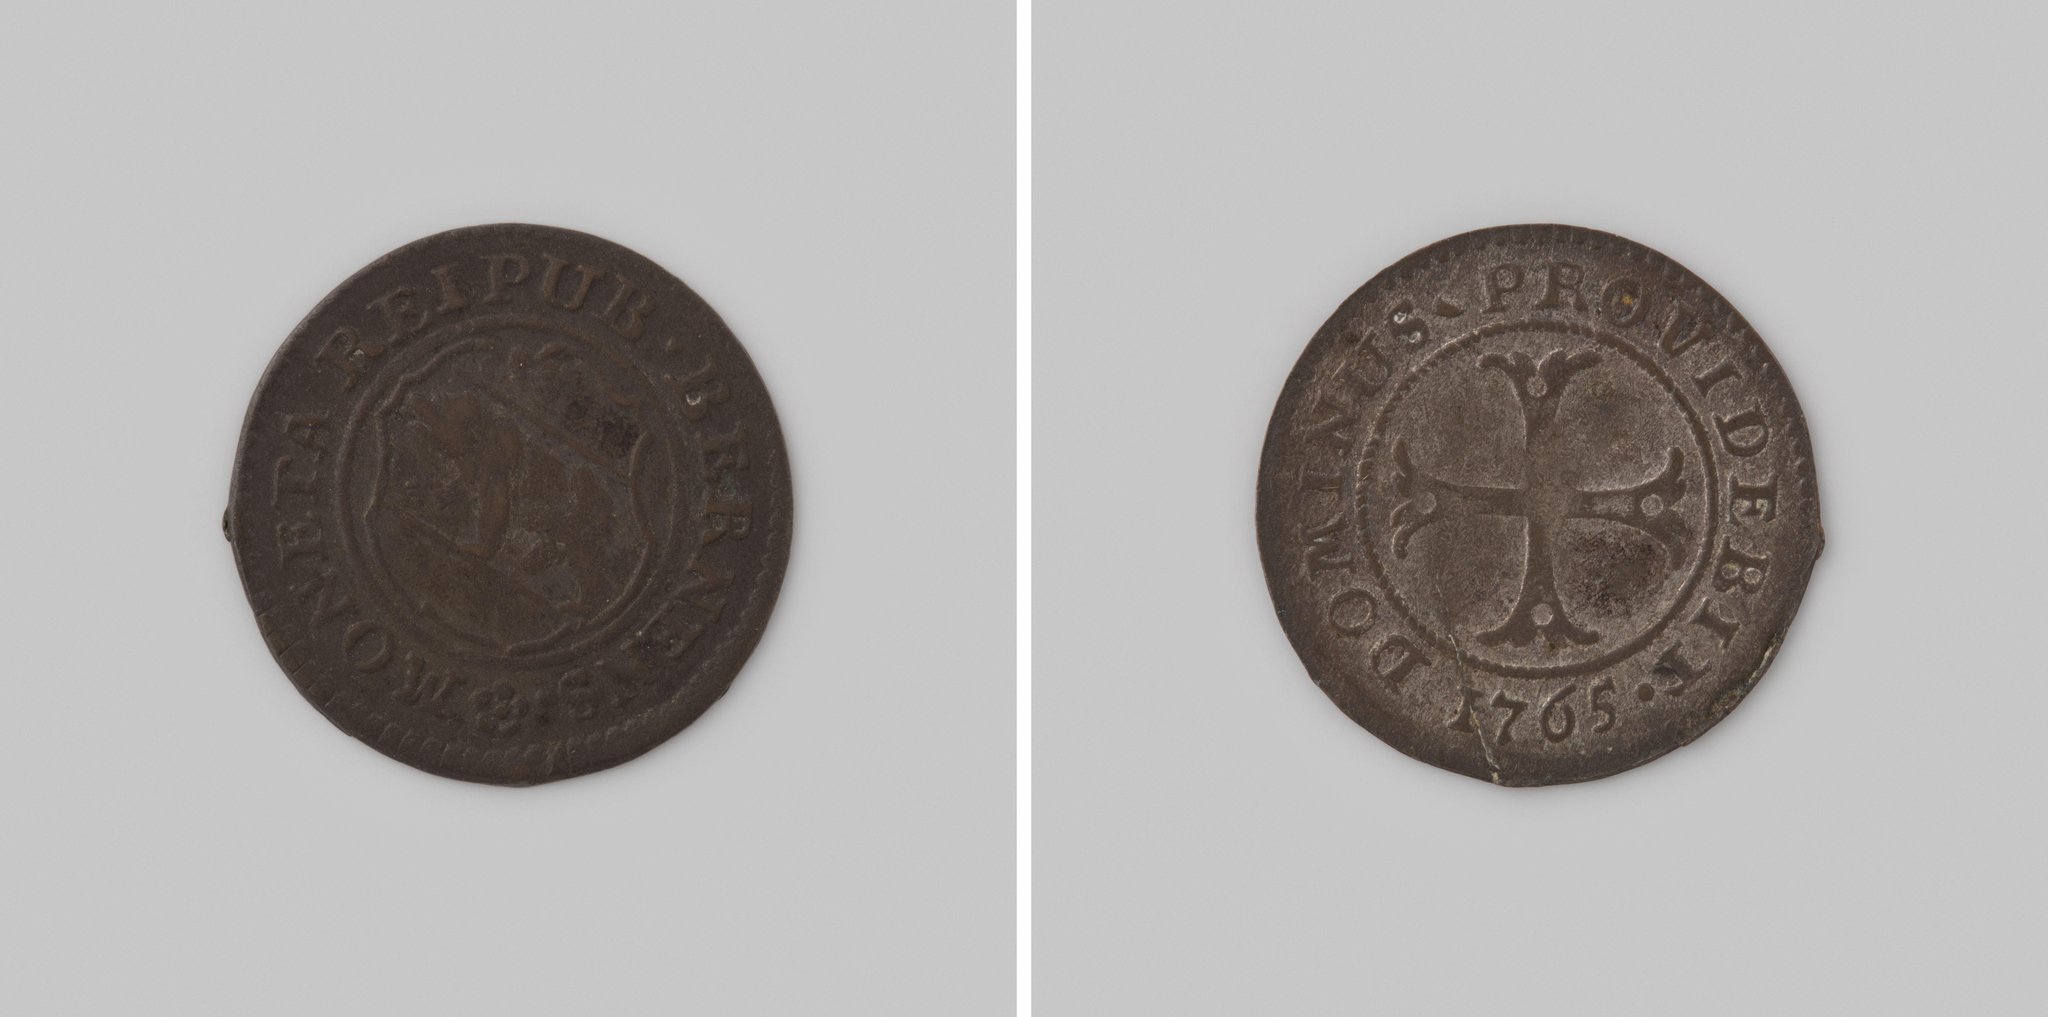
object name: coin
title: Kreuzer uit het kanton Bern, 1765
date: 1765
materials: silver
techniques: striking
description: Koper-zilveren munt. Voorzijde: wapenschild. Keerzijde: kort kruis. Jaartal onderaan in omschrift. Gladde rand.